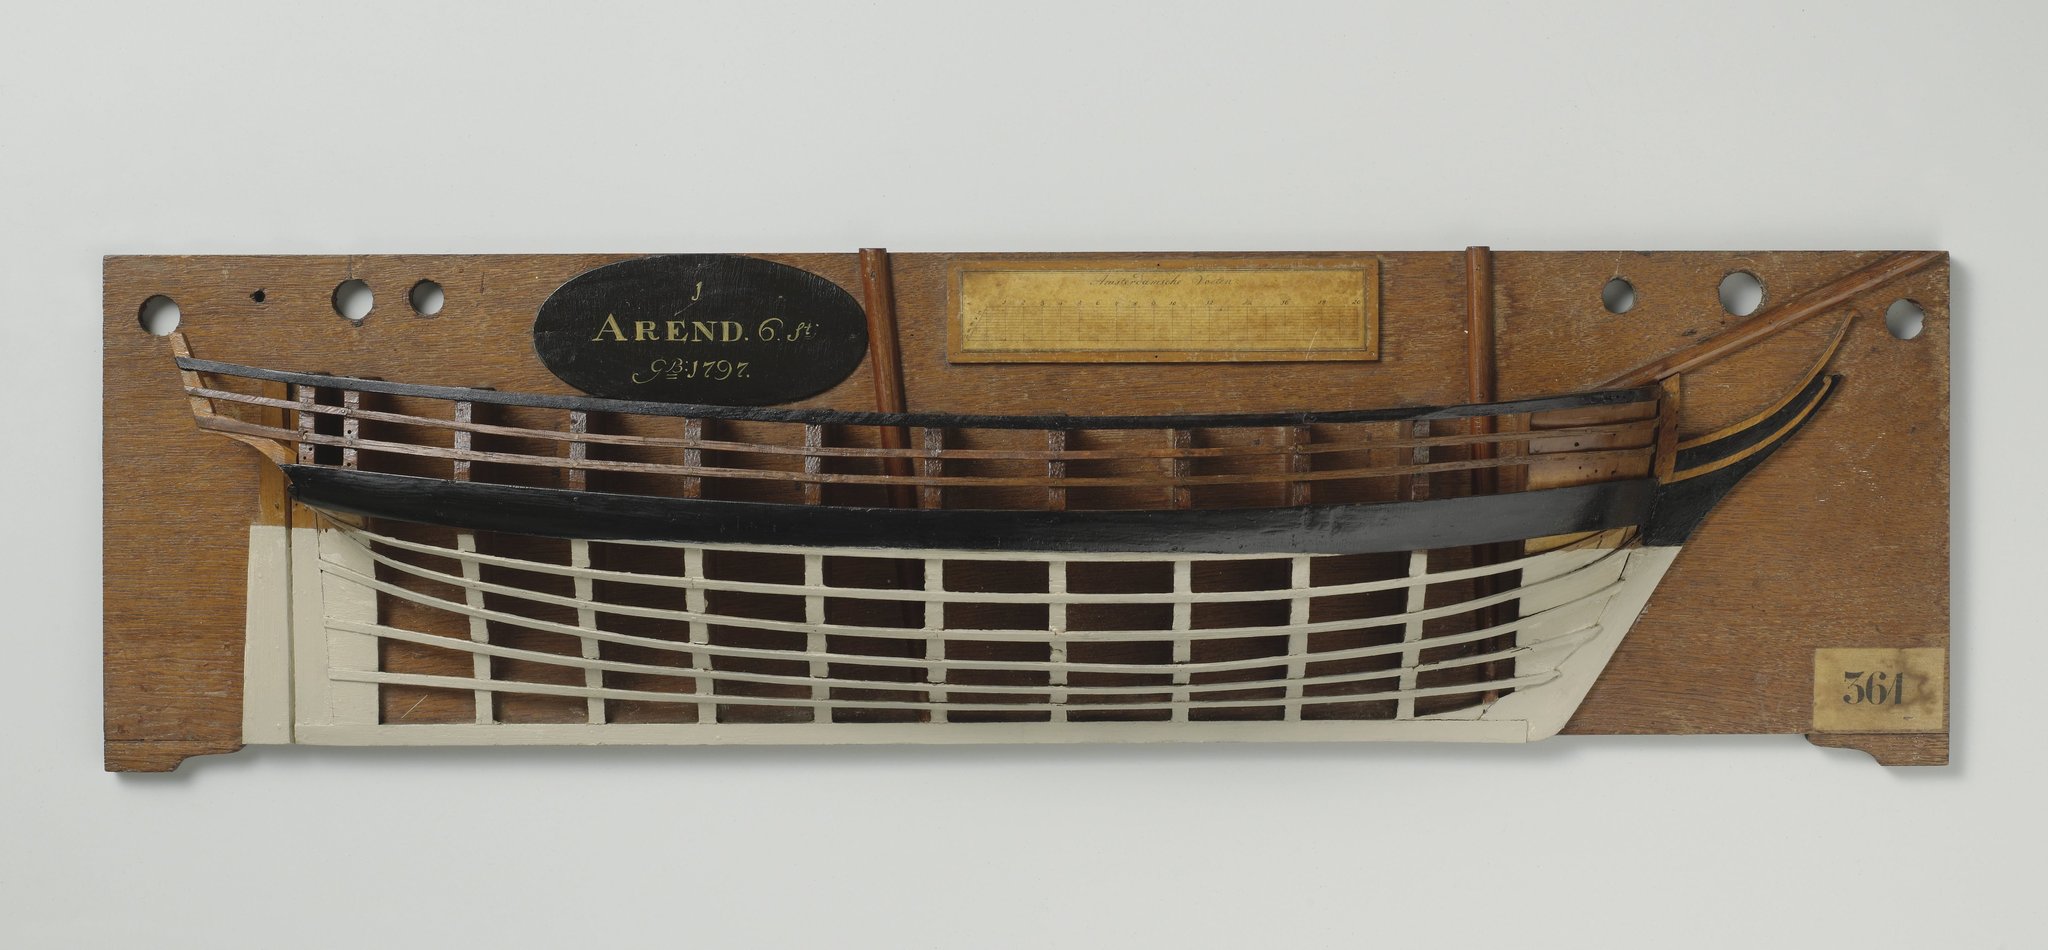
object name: builder's model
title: Half Model of a 6-Gun Brig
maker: Anonymous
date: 1797-1798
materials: wood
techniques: polychromy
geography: hoorn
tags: arend (schip)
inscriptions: scale, top centre: paper scale in Amsterdam feet, inscription, top centre, on an oval black label: ‘1 / AREND. 6. St / GB: 1797’, label, bottom right: ‘361’ former inventory label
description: De brik van 6 stukken Arend, lang 75 voet, werd in 1797-1798 in Hoorn gebouwd.